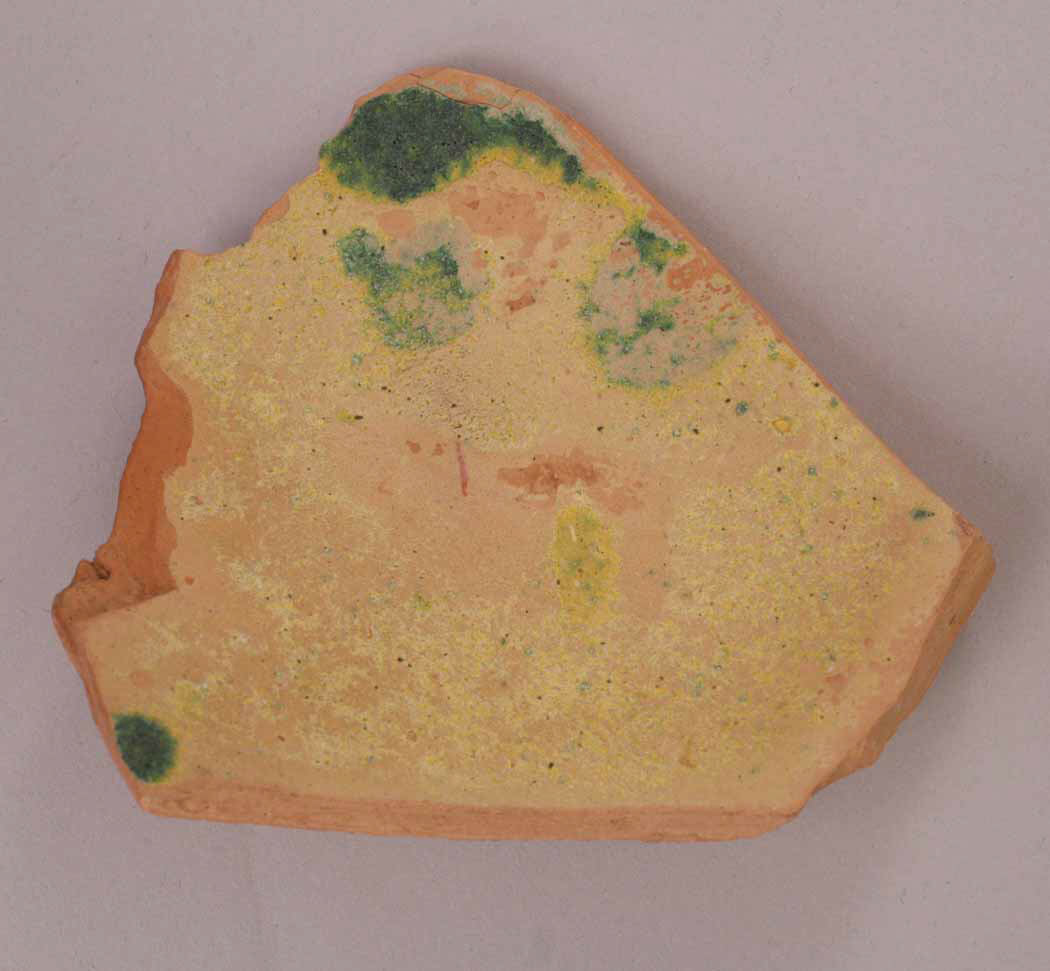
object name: fragment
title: Ceramic Fragment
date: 801-900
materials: earthenware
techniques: glazing, painting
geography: saudi arabia